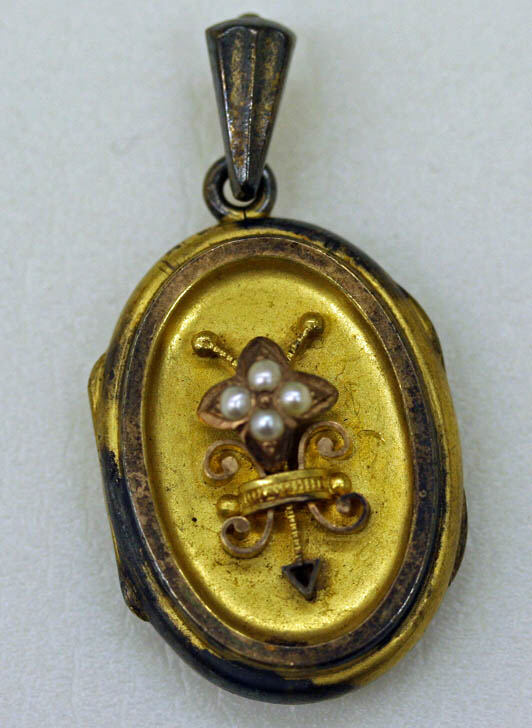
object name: locket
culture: american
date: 1875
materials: metal, pearl